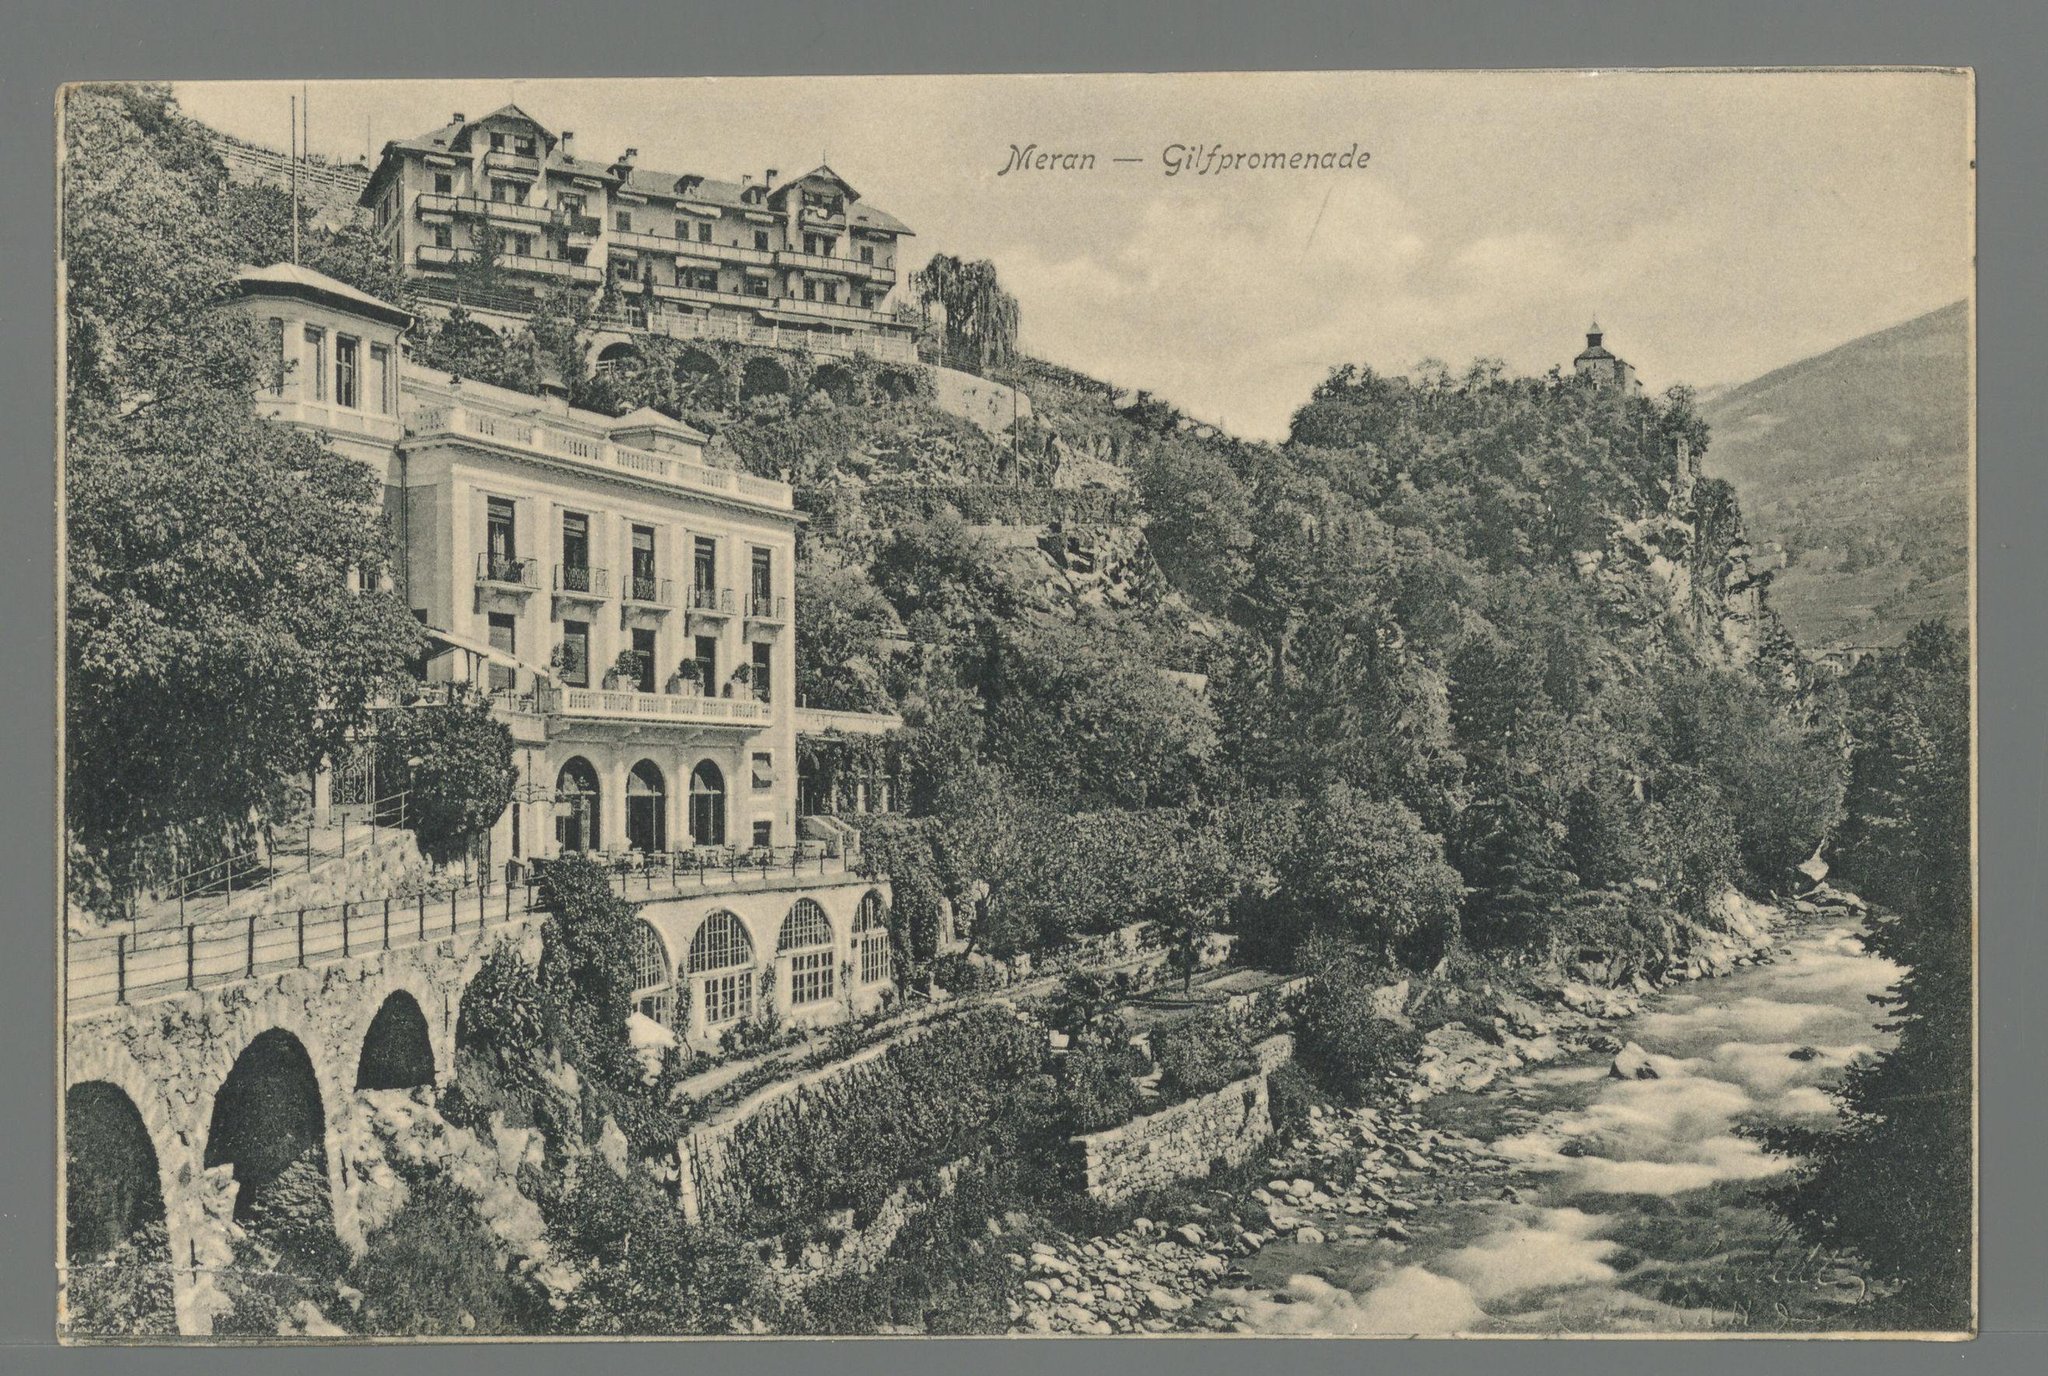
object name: ansichtkaart, prentbriefkaart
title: Meran. Gilfpromenade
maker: Anonymous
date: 1908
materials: cardboard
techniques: photograph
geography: leipzig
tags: brook, hotel, hostelry, inn, mountains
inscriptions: date